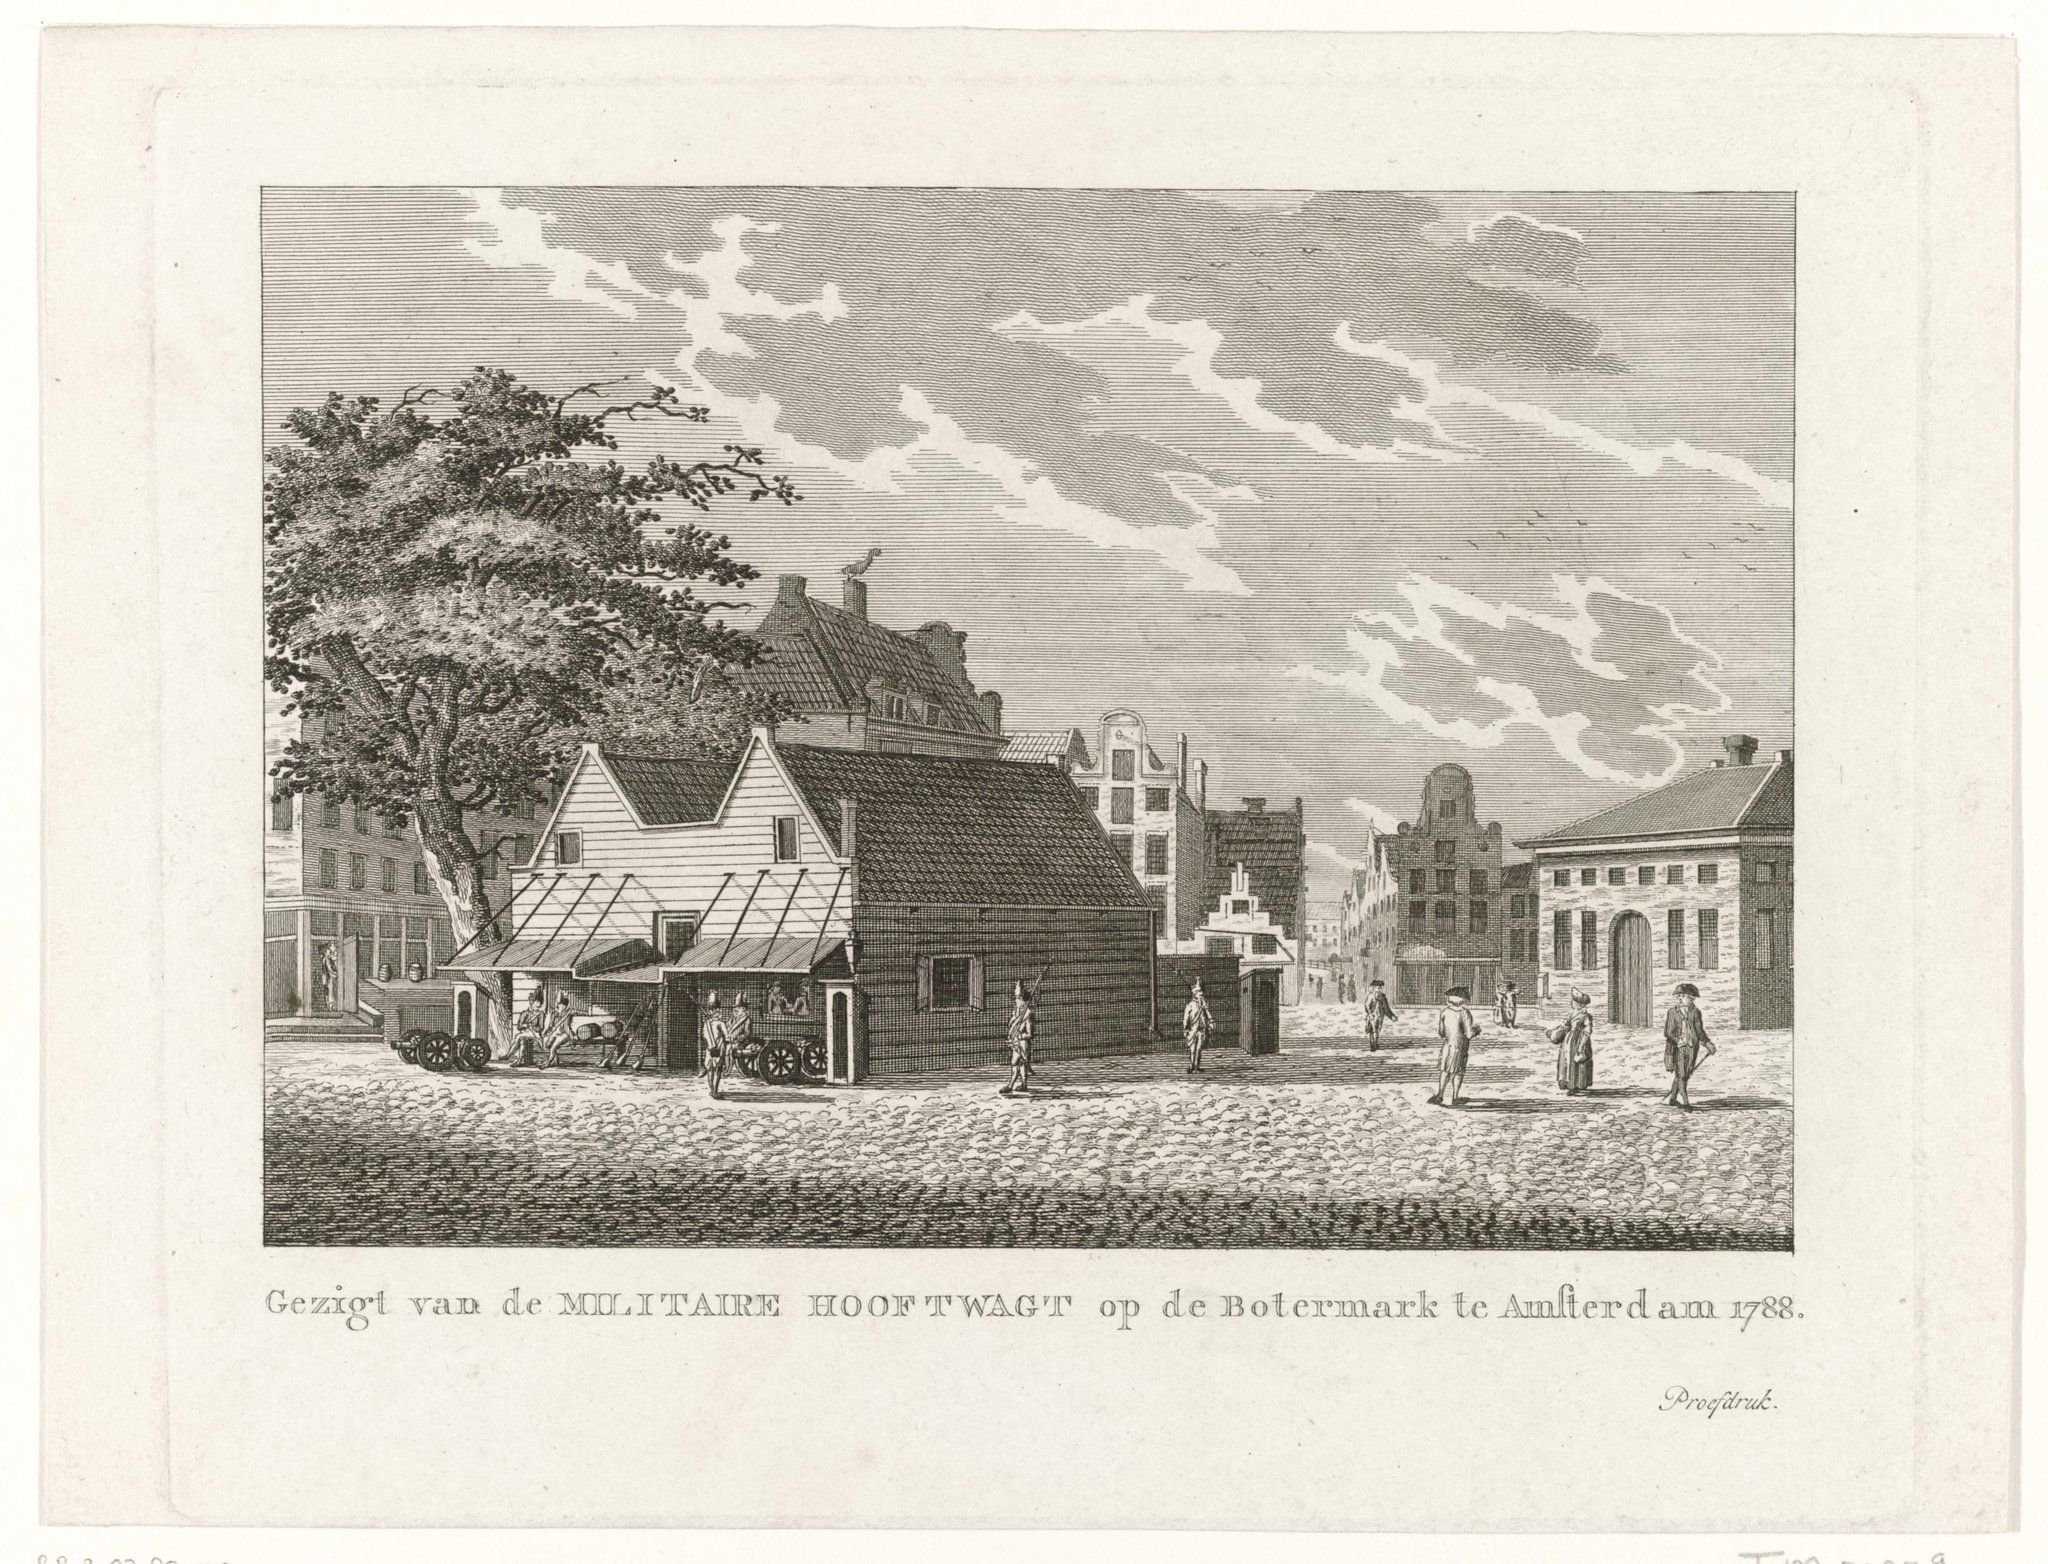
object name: print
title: Gezigt van de Militaire Hooftwagt op de Botermarkt te Amsterdam 1788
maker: jacobus wijsman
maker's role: print maker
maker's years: 1768-1827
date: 1788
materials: paper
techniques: engraving, etching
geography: northern netherlands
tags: guard duty, keeping sentry, patriots (1780-1795)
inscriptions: collector's mark: Lugt 2228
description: Gezicht op de militaire hoofdwacht van de landsmilitie op de Botermarkt (op het huidige Rembrandtsplein) te Amsterdam, 1788.